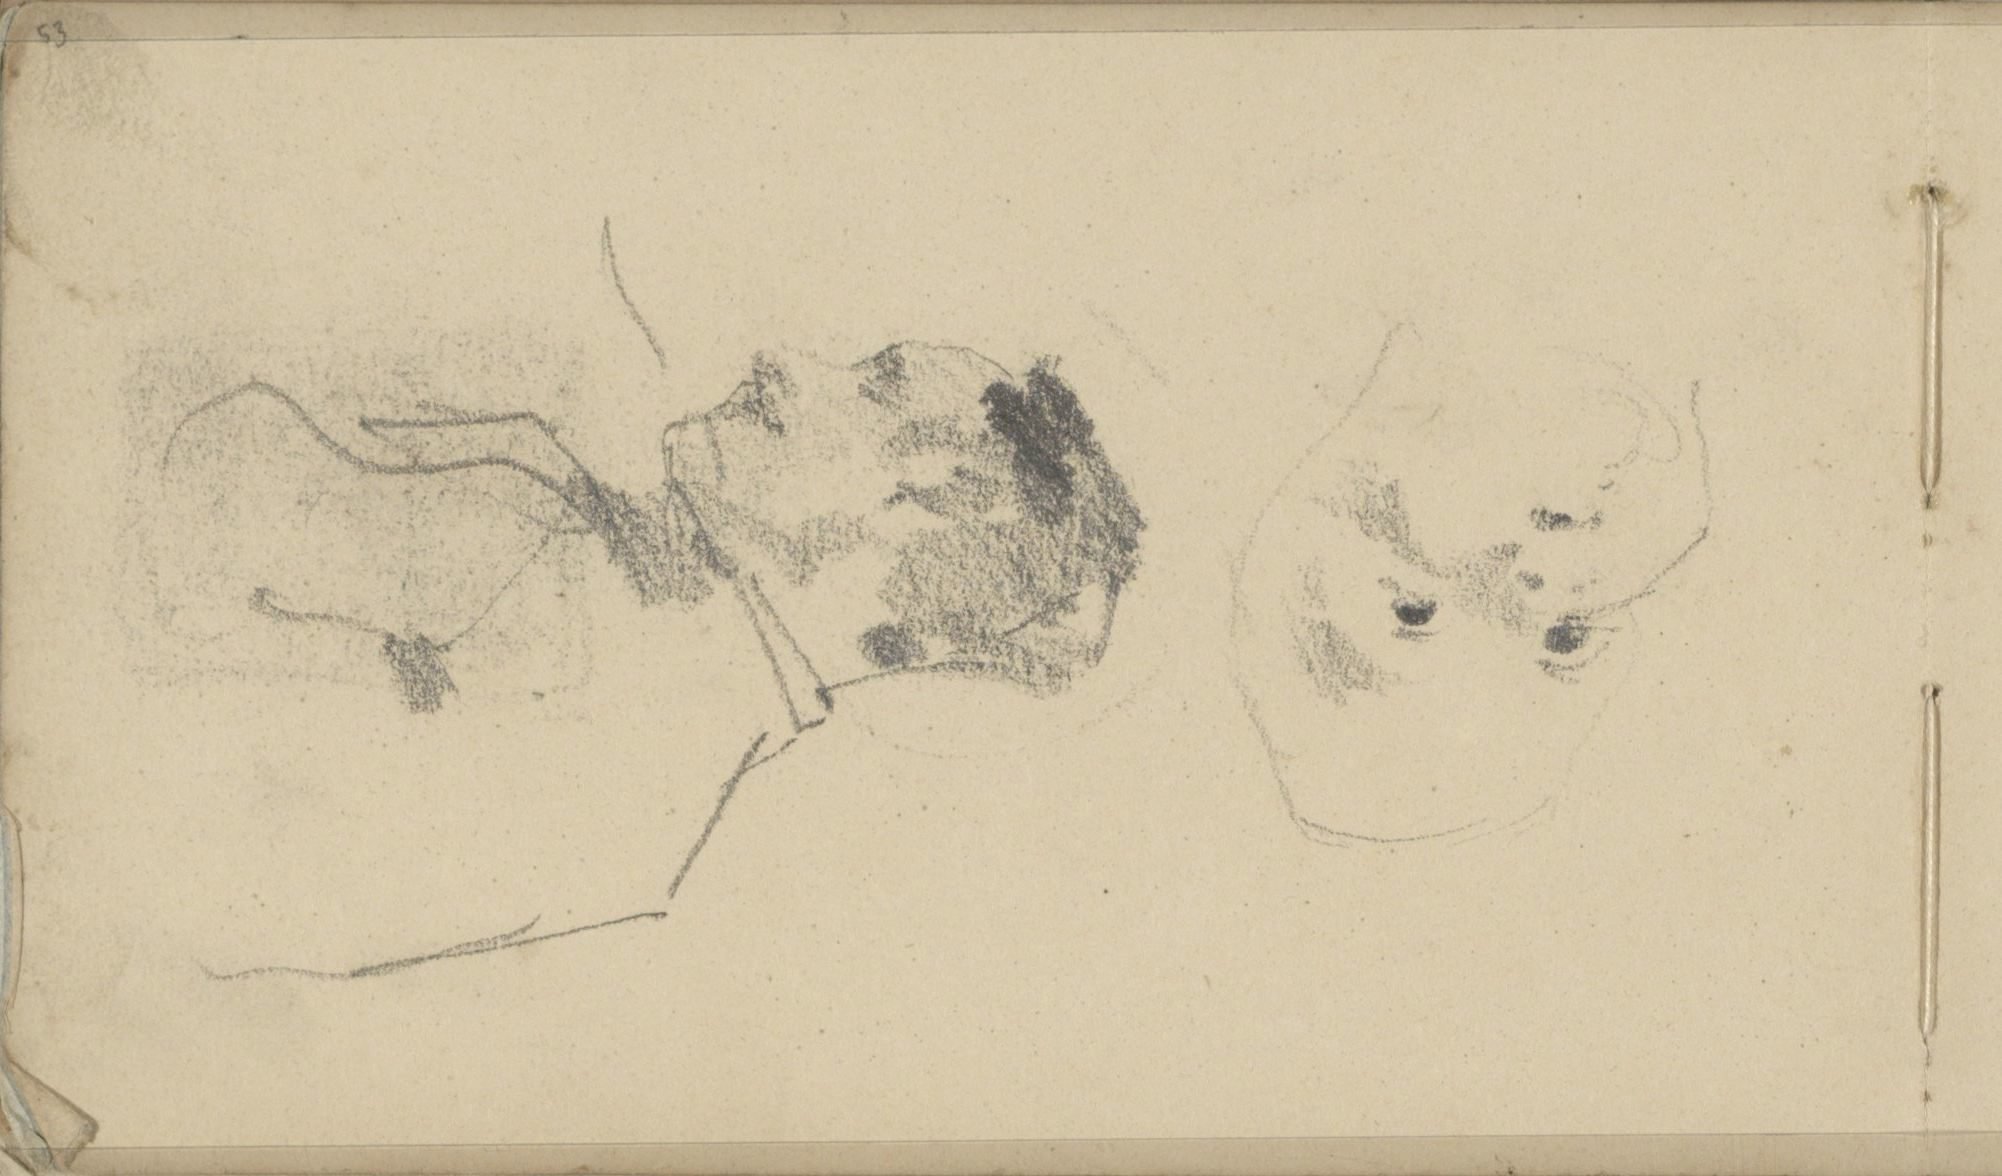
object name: sketchbook leaf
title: Kinderhoofd en een man in profiel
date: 1881-1883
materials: paper, pencil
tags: head (human), child, adult man (+ sideview, profile)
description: Pagina 53 uit een schetsboek met 30 bladen.